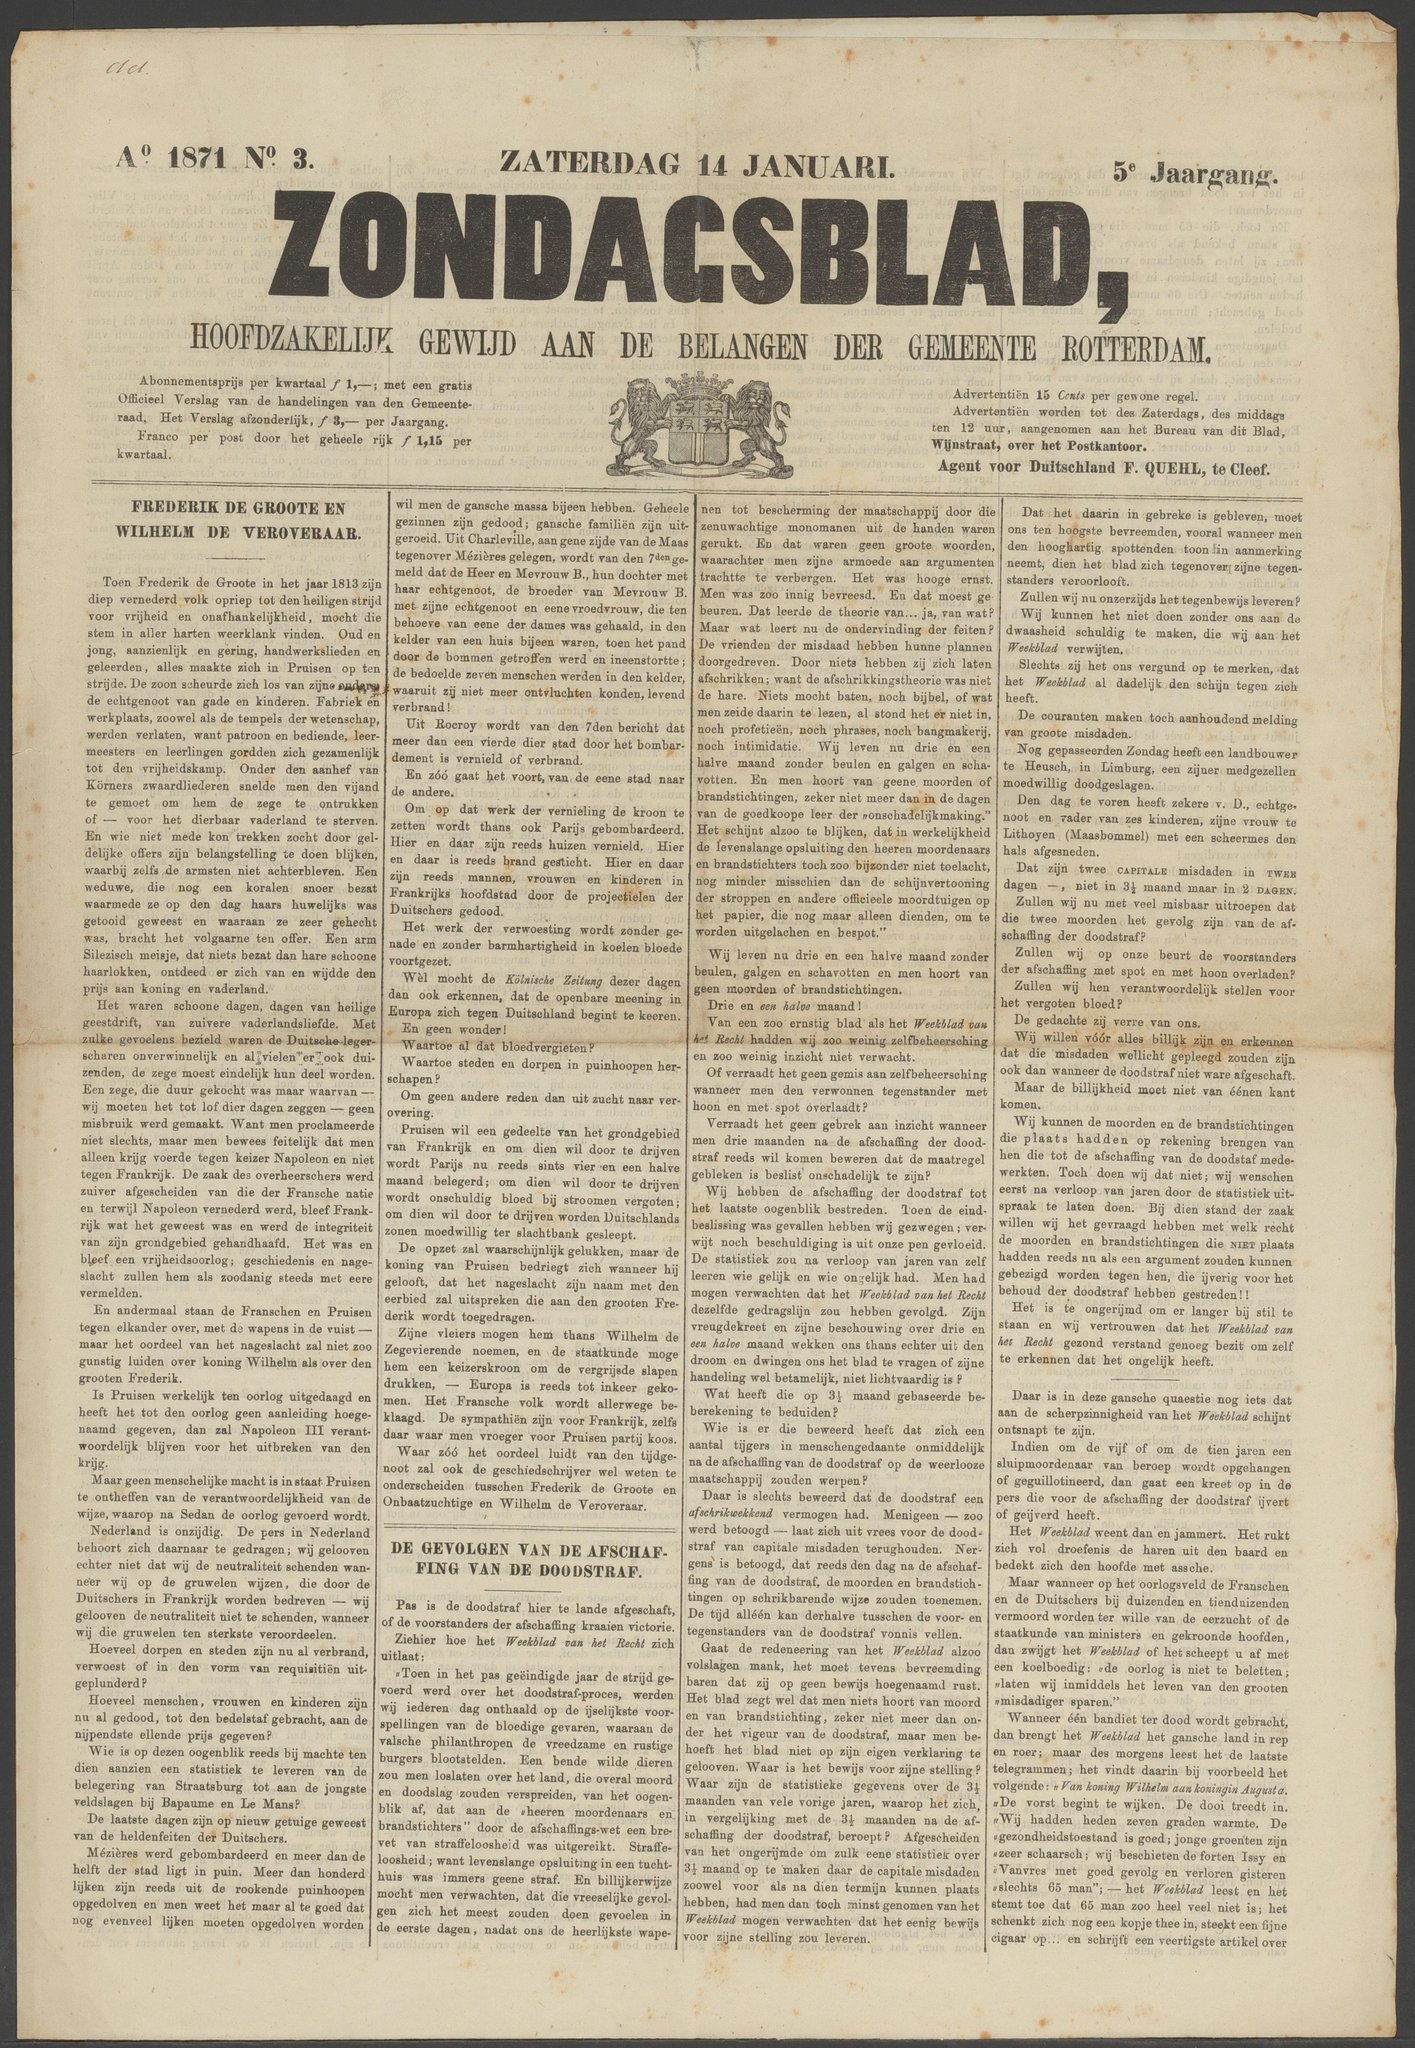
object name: newspaper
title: Zondagsblad, 14 januari 1871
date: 1871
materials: paper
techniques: letterpress printing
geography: rotterdam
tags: newspaper, news-sheet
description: Exemplaar van de krant 'Zondagsblad, hoofdzakelijk gewijd aan de belangen der gemeente Rotterdam', 14 januari 1871. Bovenaan een vignet met het stadswapen van Rotterdam. Dubbelbladig, alle zijden bedrukt. Onderwerpsrubrieken binnen de Atlas Zeden en Gewoonten: Regeering, Officieele Nieuwsbladen.